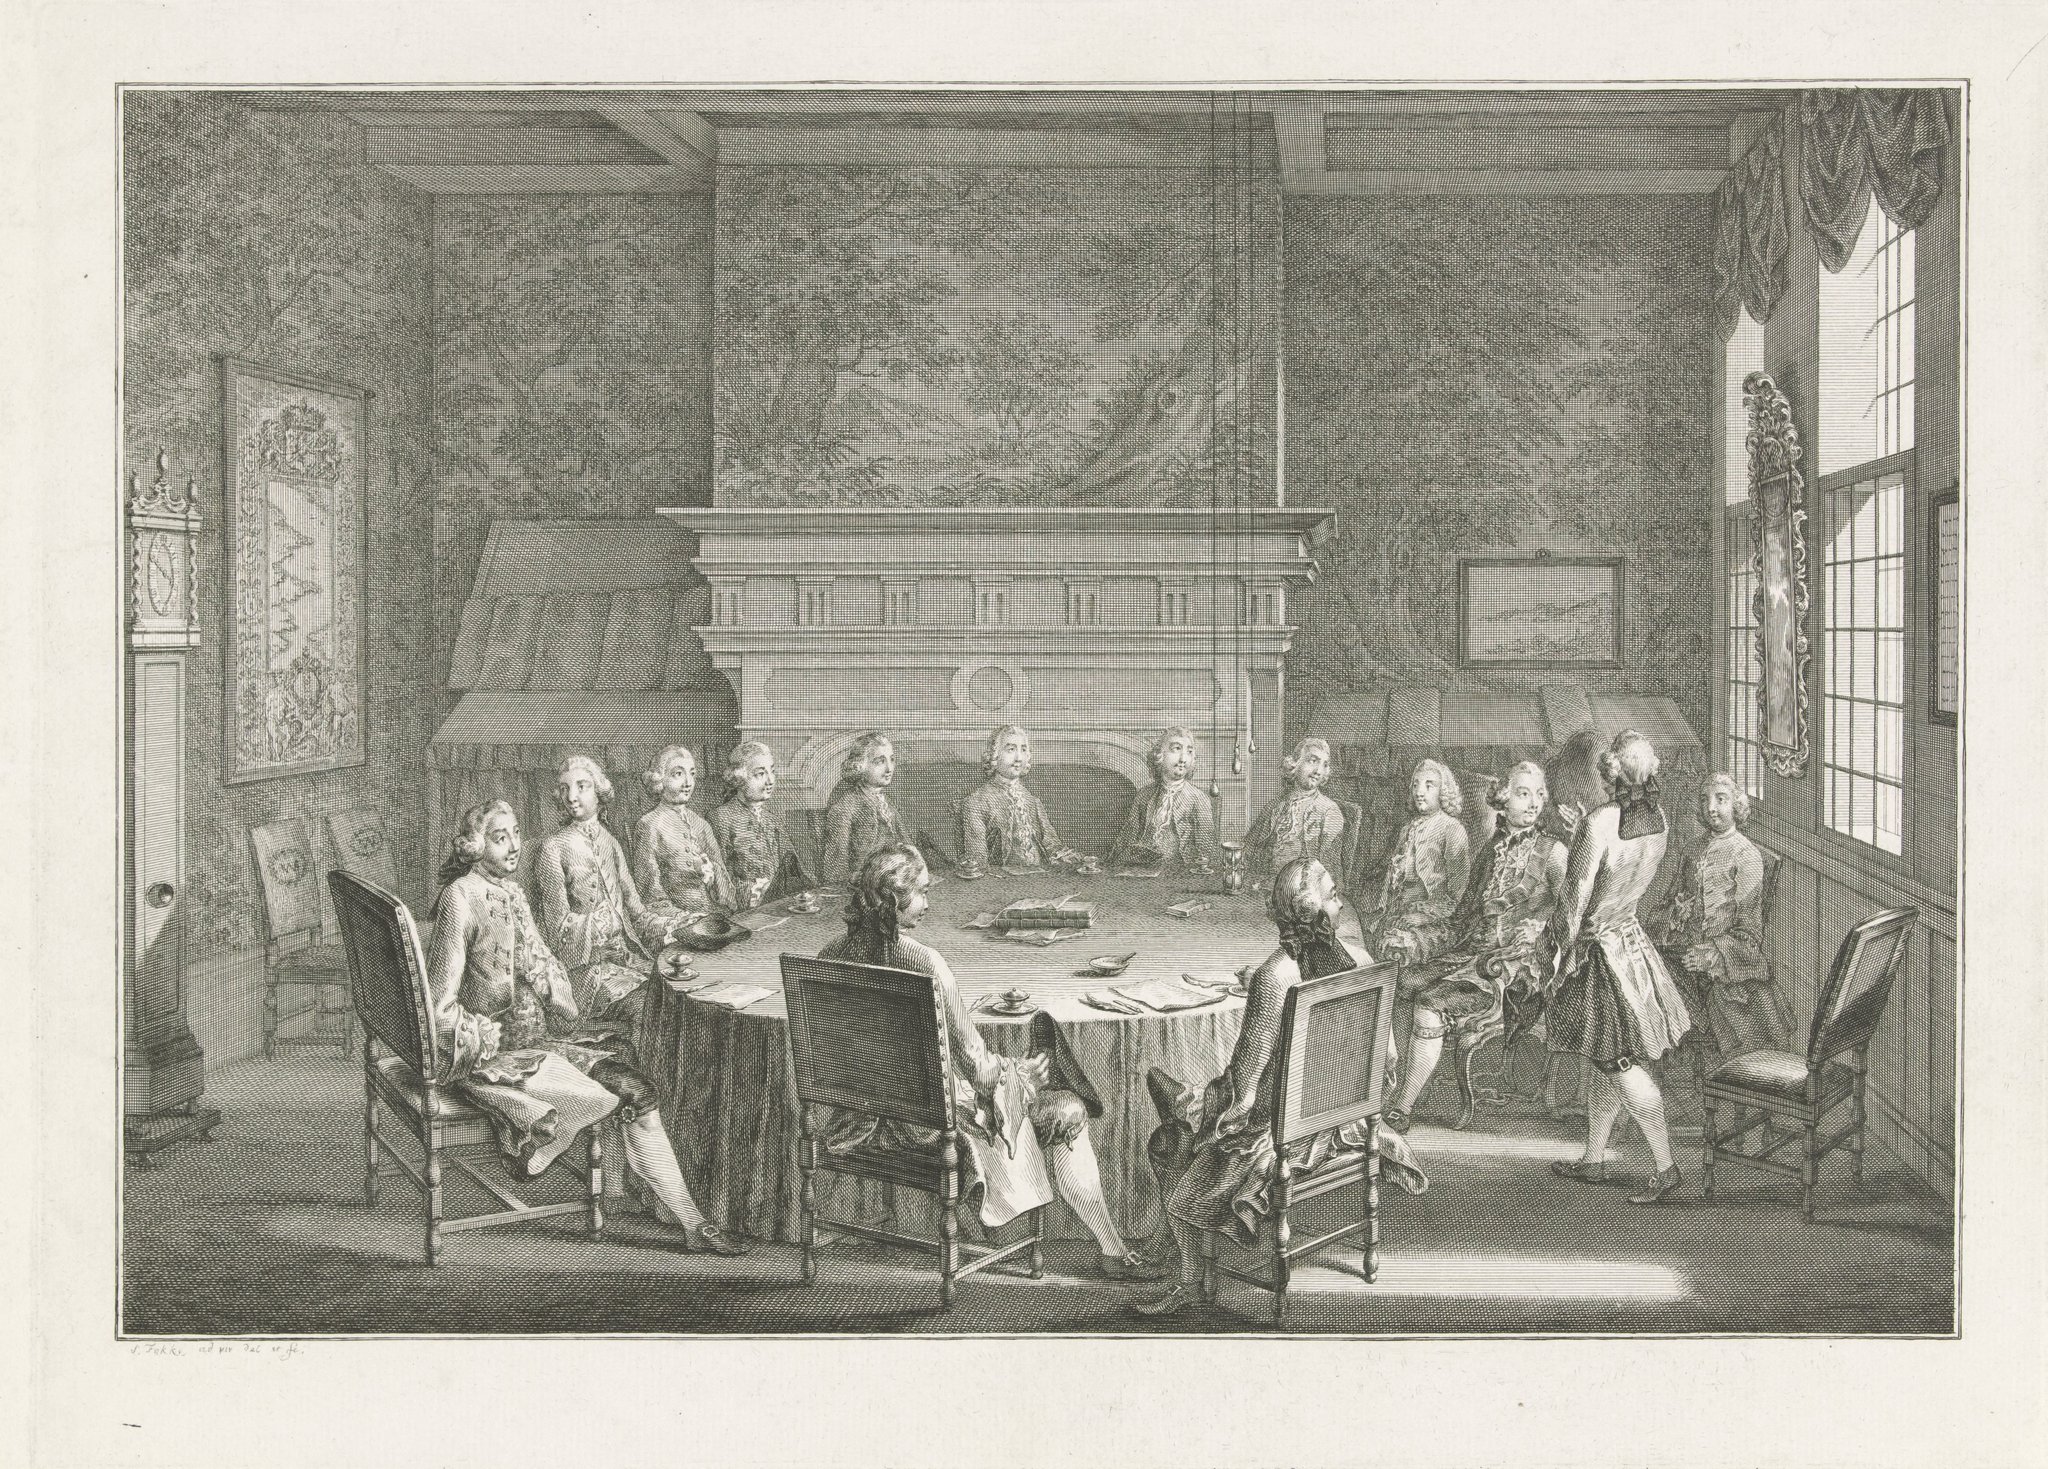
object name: print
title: Afbeelding der Vreugdebedryven en Plegtigheden die by de aankomst en gedurende het verblyf (...) Willem (...) en zyne Gemaalinne (...) zyn voorgevallen te Amsterdam, op maandag, den 30 Mey, en eenige volgende dagen, des jaars 1768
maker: simon fokke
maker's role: draughtsman, print maker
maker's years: 1712-1784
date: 1769-1773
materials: paper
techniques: engraving, etching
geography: northern netherlands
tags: the hague, william v (prince of orange), berlin, draughtsman, wilhelmina of prussia (princess of orange), meeting, assembly, amsterdam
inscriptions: collector's mark: Lugt 2228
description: Stadhouder Willem V neemt als opperbewindhebber zitting tussen de directeuren van de WIC te Amsterdam, 1 juni 1768. Onderdeel van een prentserie met titelprent en 14 platen van de inhaling van de prins en prinses te Amsterdam, 30 mei - 4 juni 1768.